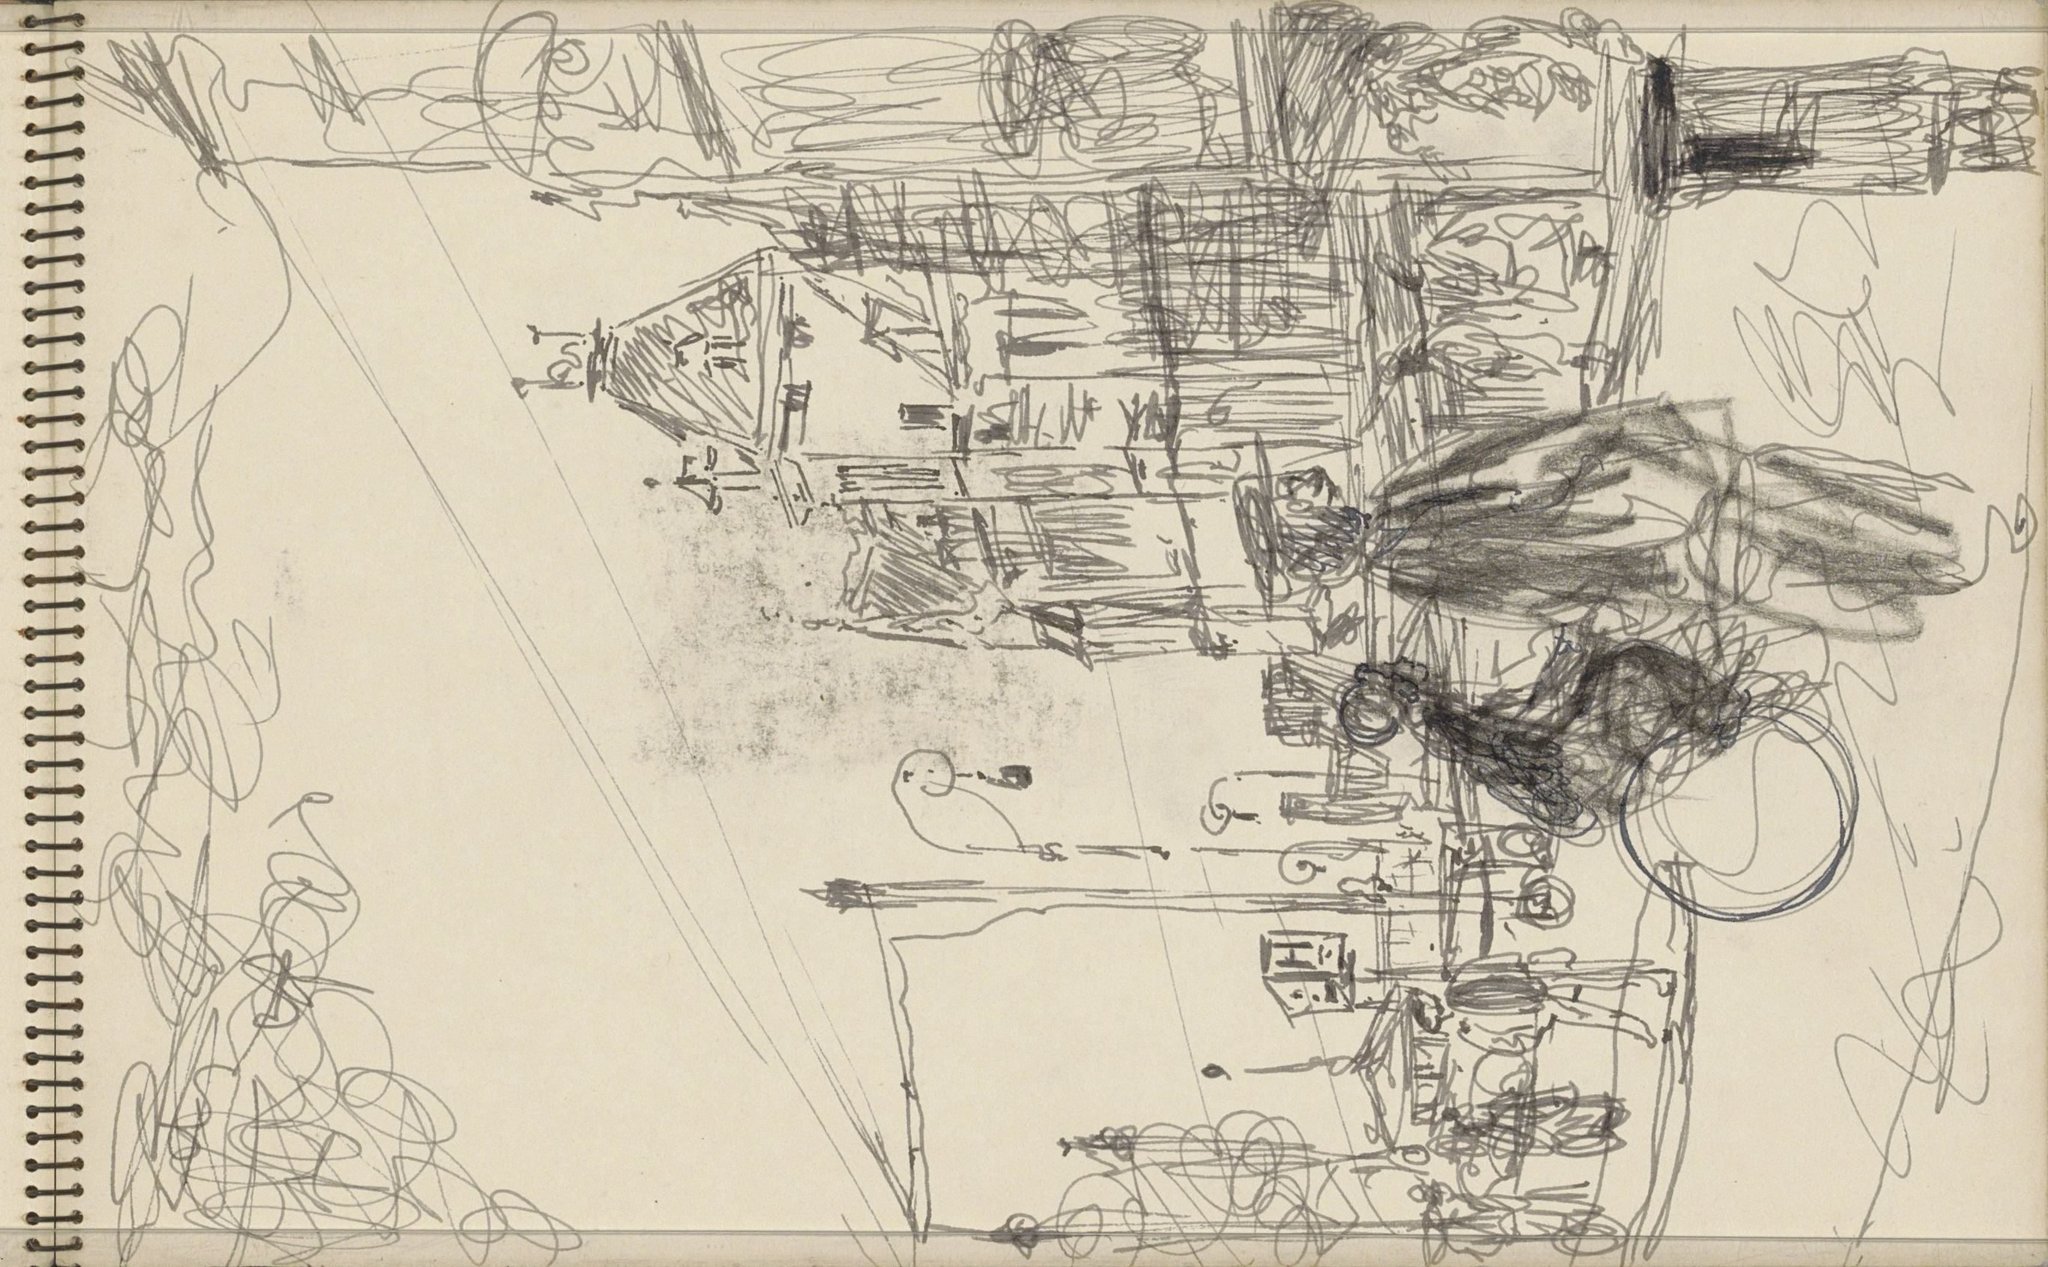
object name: sketchbook leaf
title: Straat met figuren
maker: carel adolph lion cachet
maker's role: draughtsman, print maker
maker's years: 1864-1945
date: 1930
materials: chalk, ink, paper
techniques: pen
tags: street (+ city(-scape) with figures, staffage)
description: Blad 2 recto uit een schetsboek met 14 bladen.